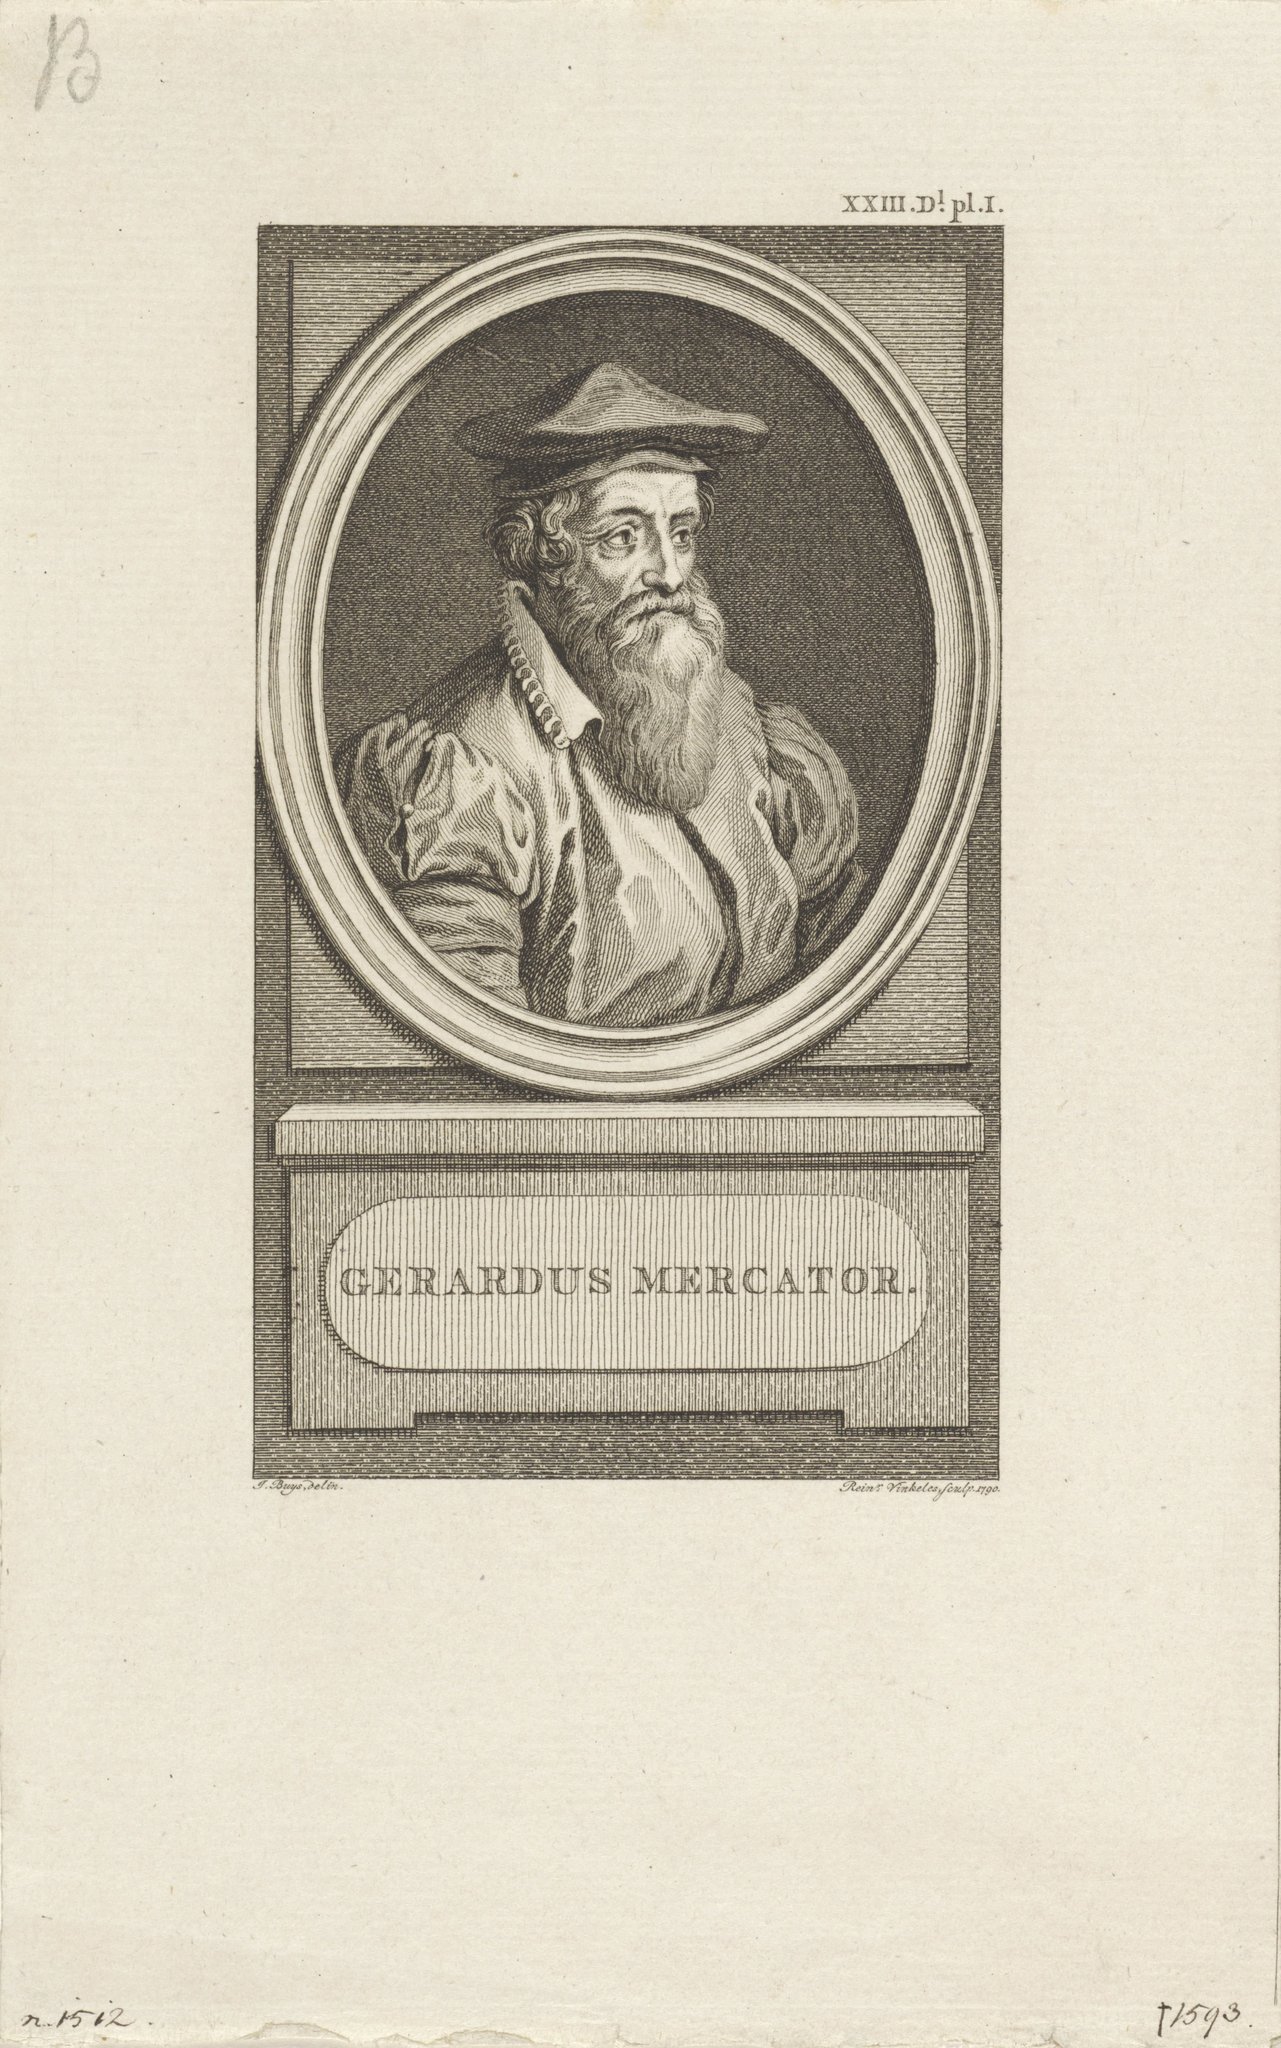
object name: print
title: Portret van de cartograaf Gerardus Mercator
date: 1790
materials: paper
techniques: etching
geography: amsterdam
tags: instrument maker, gerardus mercator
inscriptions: collector's mark: Lugt 2228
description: Prent gebruikt als boekillustratie in: Kok, Jacobus. Vaderlandsch woordenboek : met kaarten, plaaten en pourtraitten. Amsterdam: Johannes Allart, 1785-1796. Deel XXIII.